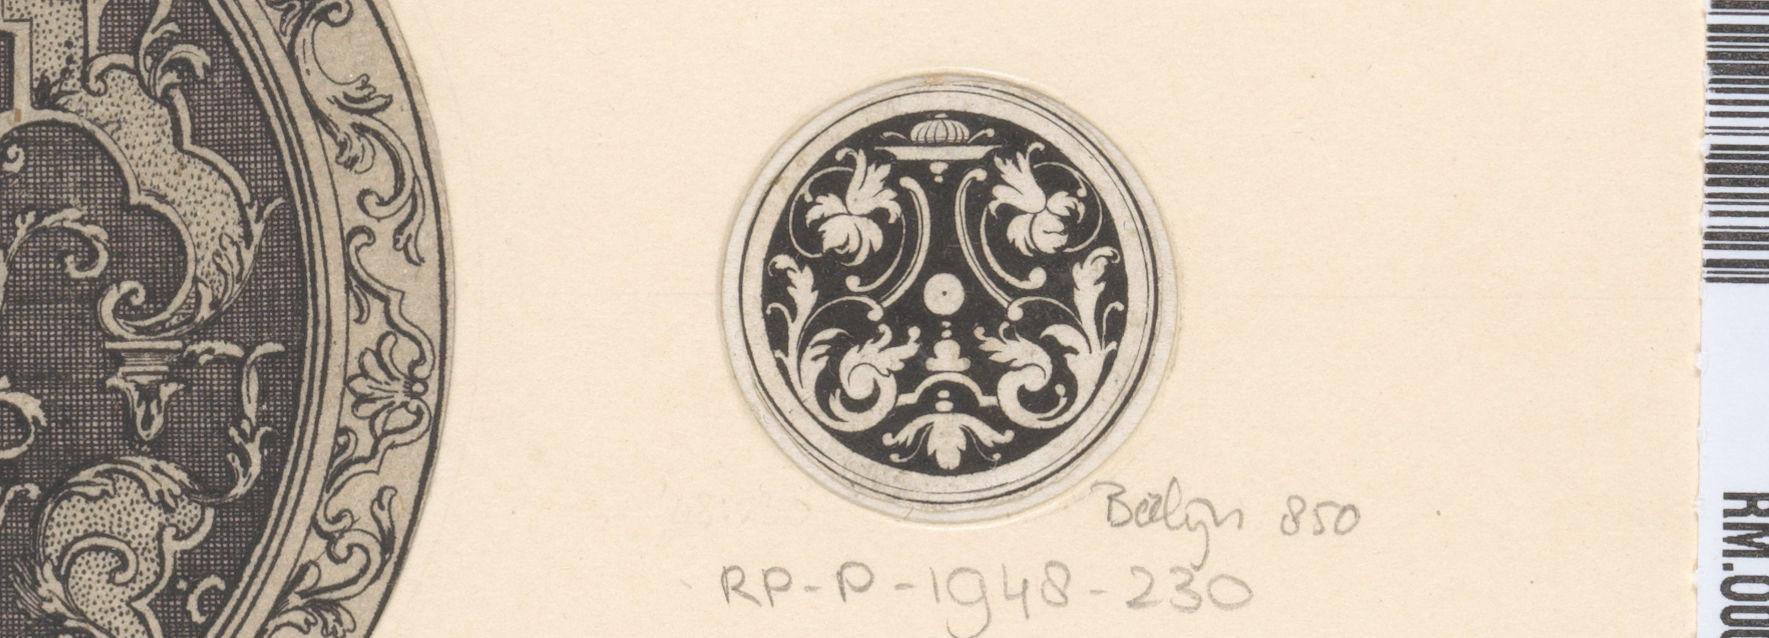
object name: ornament print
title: Livre Second Essais de Gravure (...)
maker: pierre bourdon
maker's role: print maker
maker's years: 1656-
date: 1703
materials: paper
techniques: etching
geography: paris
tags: ornament derived from plant forms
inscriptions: collector's mark: Lugt 2228, collector's mark: Lugt 1403b